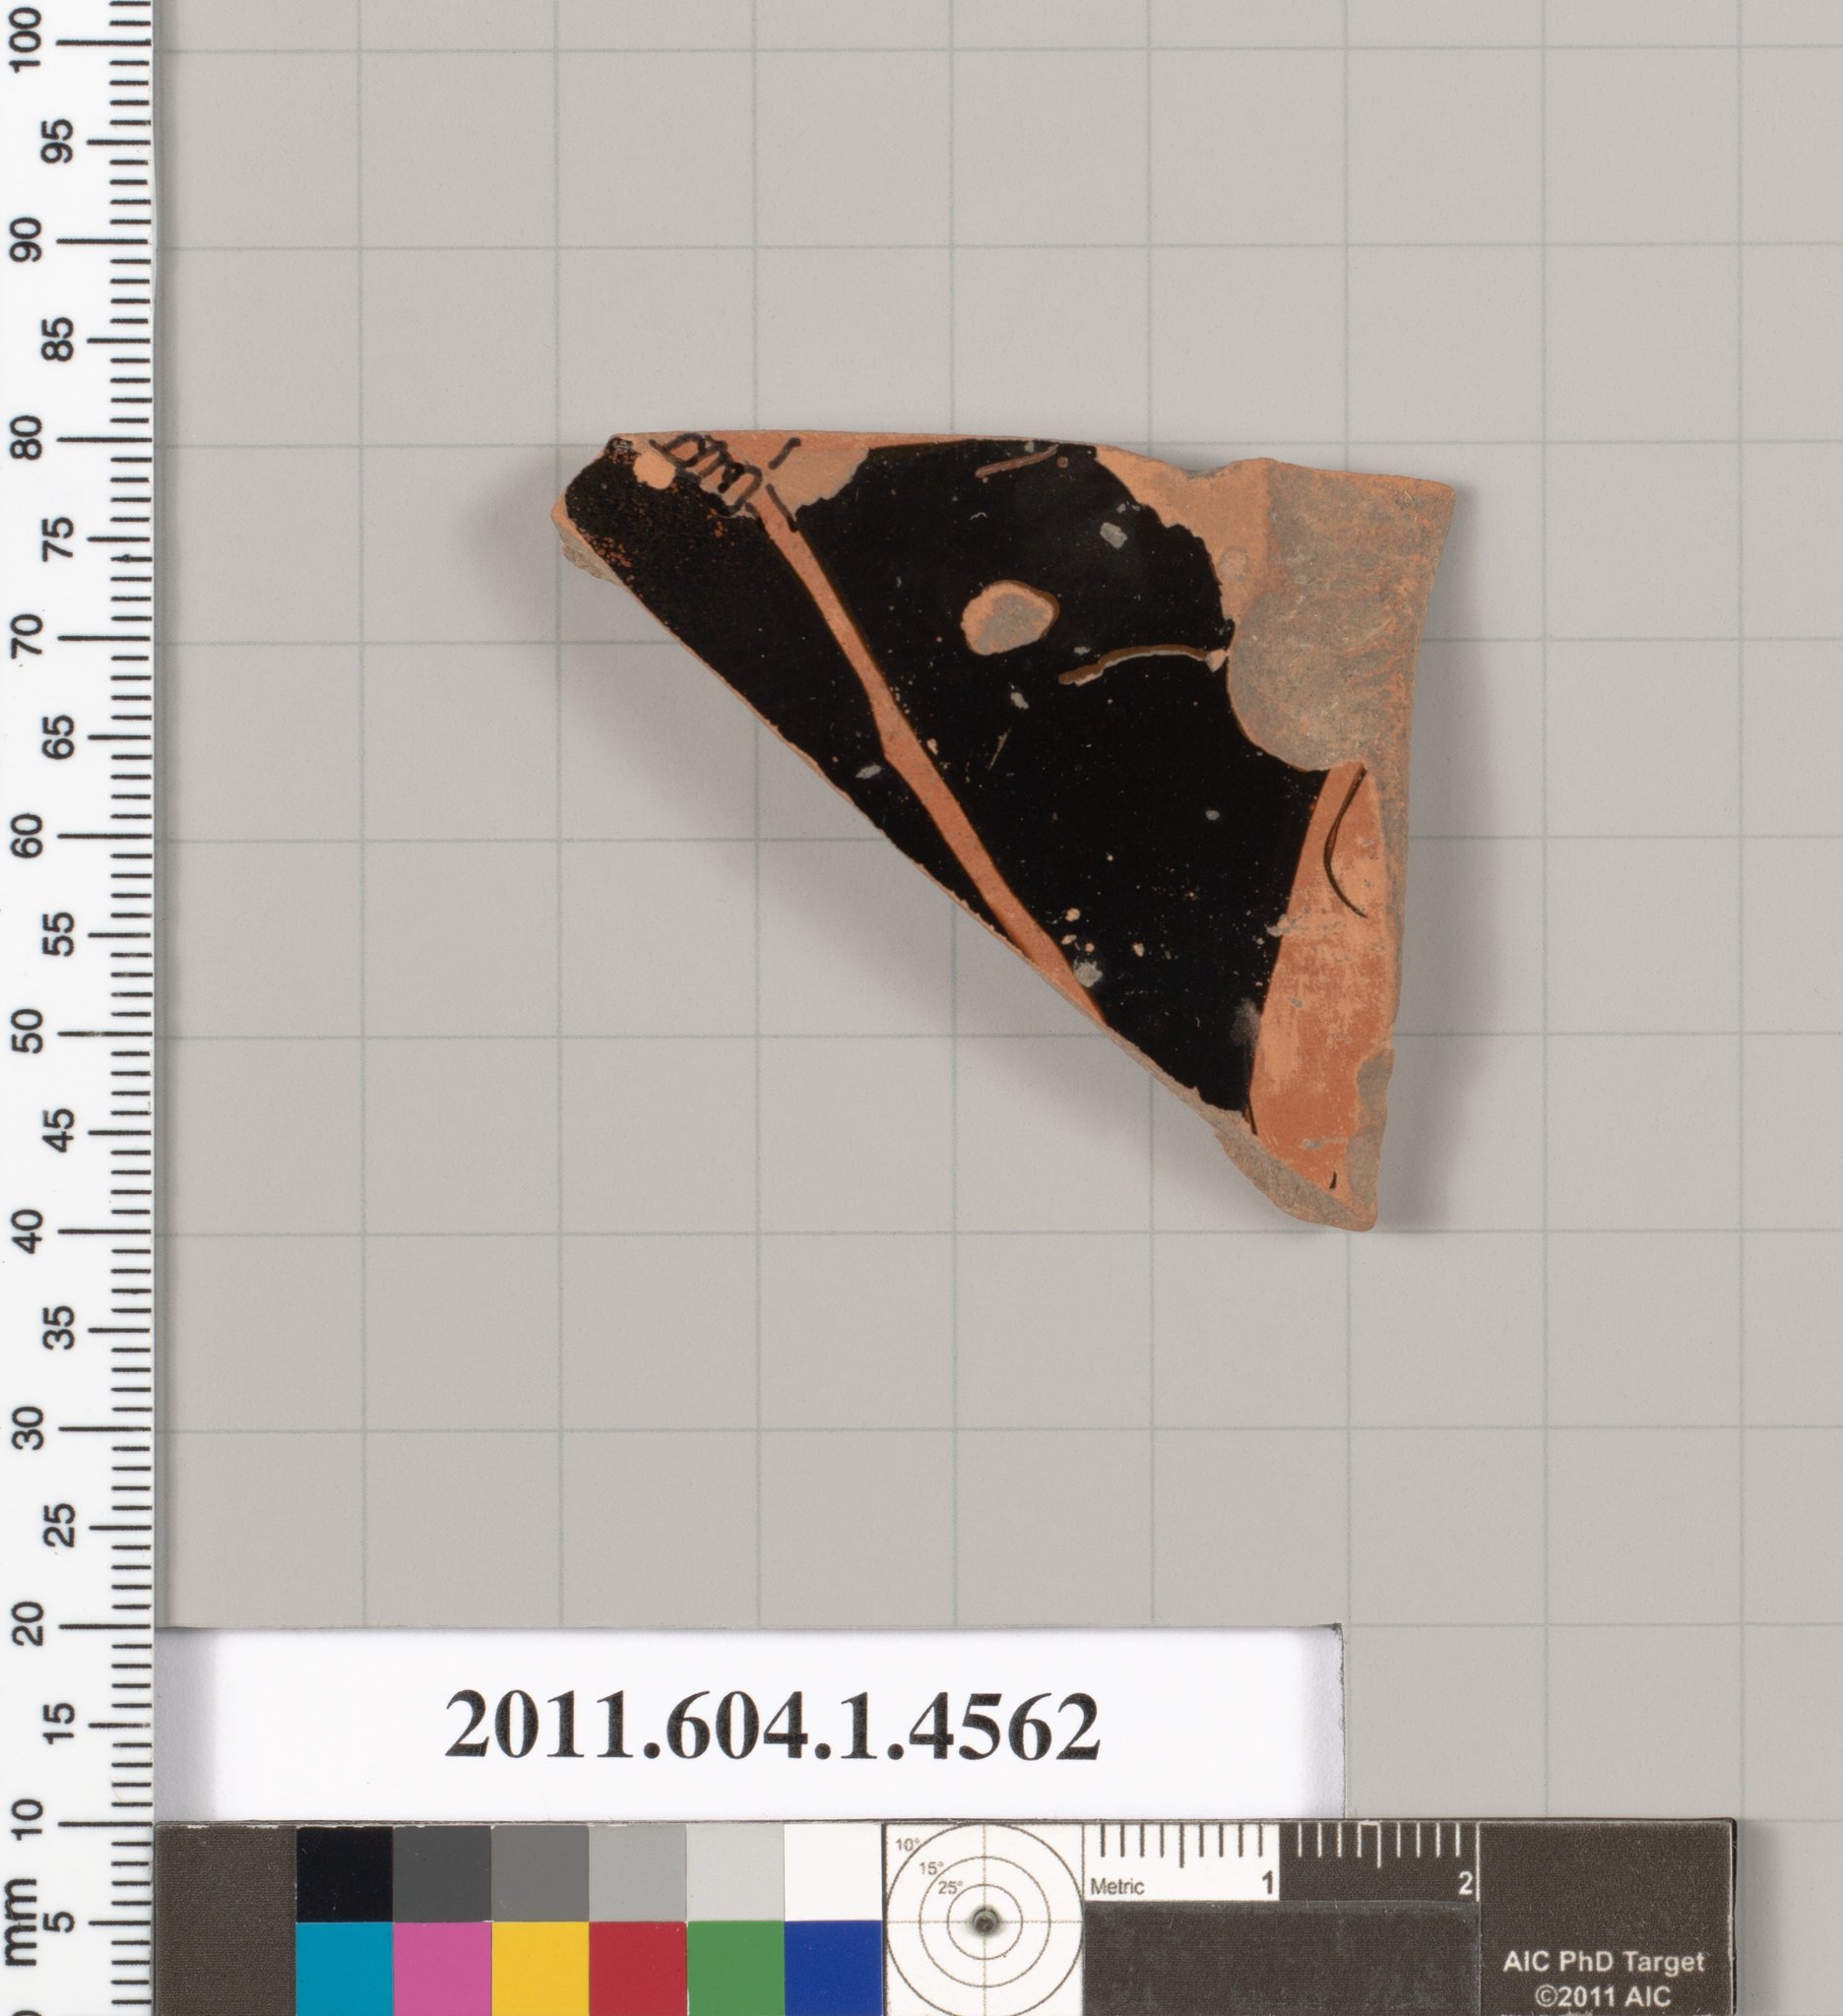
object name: kylix fragment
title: Terracotta fragment of a kylix (drinking cup)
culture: greek, attic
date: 480-470 BCE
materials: terracotta